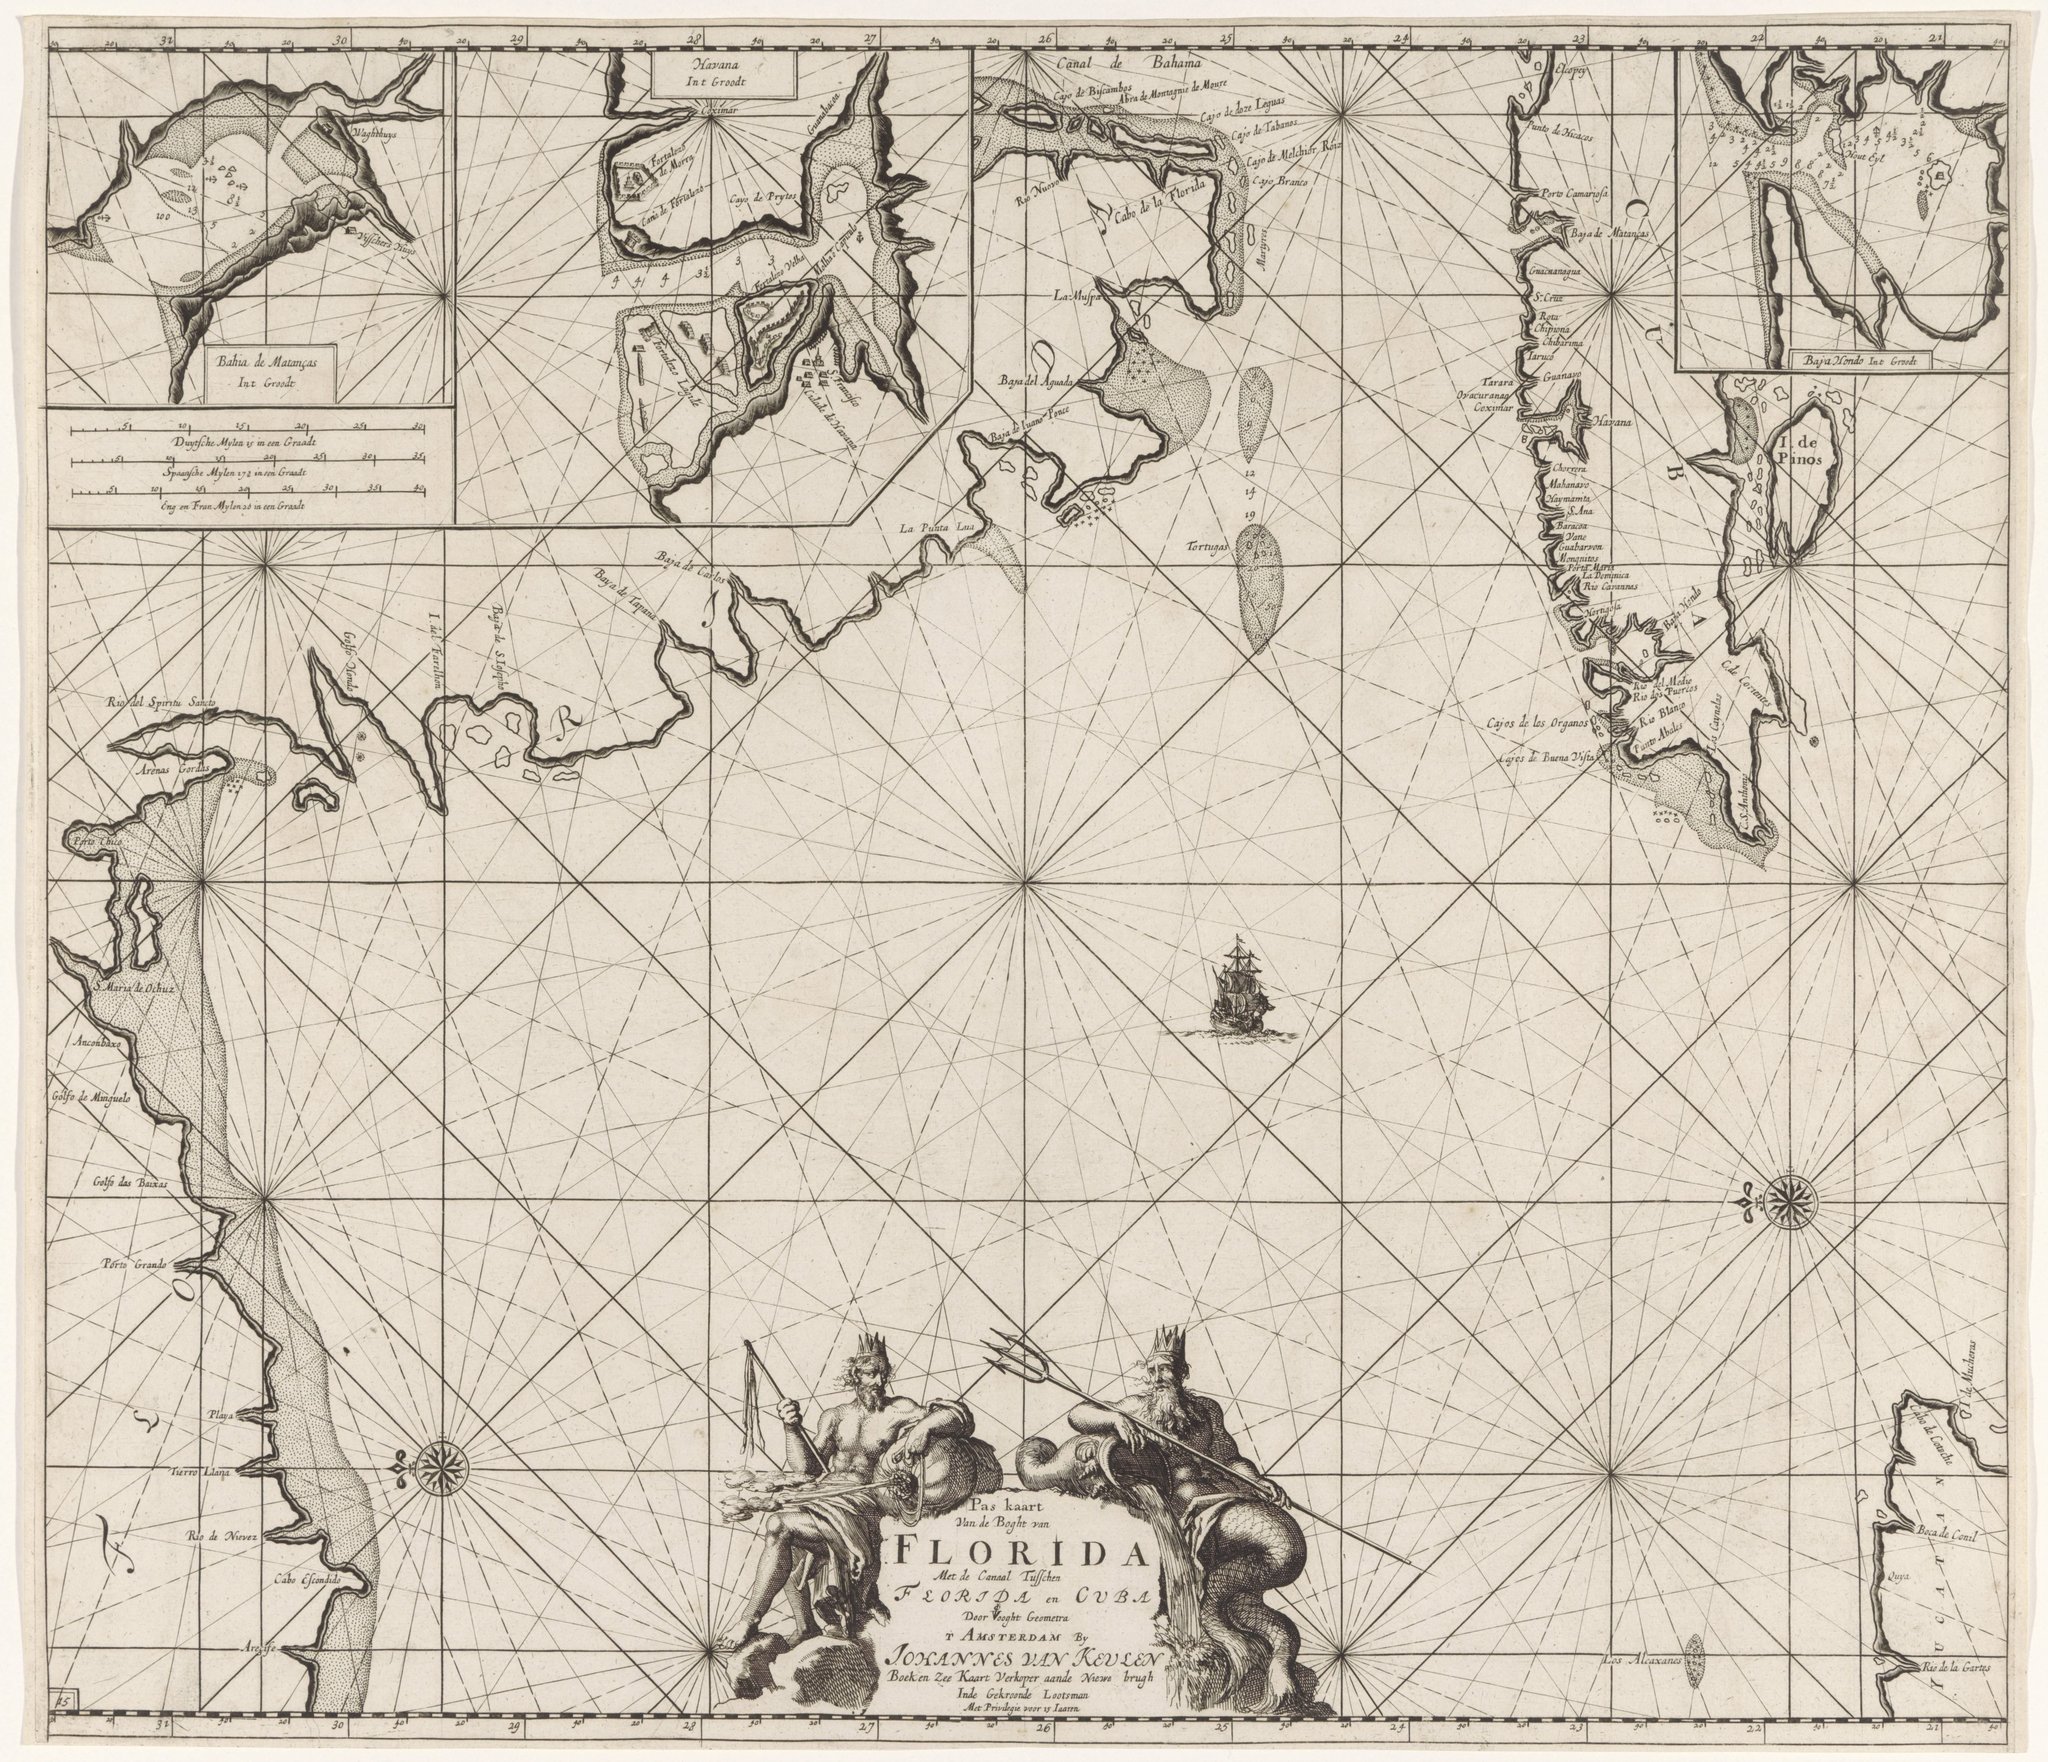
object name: print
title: Paskaart van een deel van de Golf van Mexico, met de westkust van Florida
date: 1684-1799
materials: paper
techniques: engraving, etching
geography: amsterdam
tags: sailing-ship, sailing-boat, merman, (story of) aeolus, guardian of the winds; 'eolo' (ripa) - attributes, attributes of neptune: trident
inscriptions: collector's mark: Lugt 2228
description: Paskaart van een deel van de Golf van Mexico, met de westkust van Florida en een de deel van het noorden van Cuba met de Straat van Florida, met een inzetkaart van Havana en twee baaien op Cuba. De kaart bevat twee kompasrozen, het Noorden ligt links. Middenonder de titel en het uitgeversadres geflankeerd door een gekroonde Neptunus met een drietand en een gekroonde Aeolus met windzak. Linksboven de schaalverdeling, weergegeven in Duitse, Spaanse en Engelse of Franse mijlen (schaal: c. 1:2.000.000).